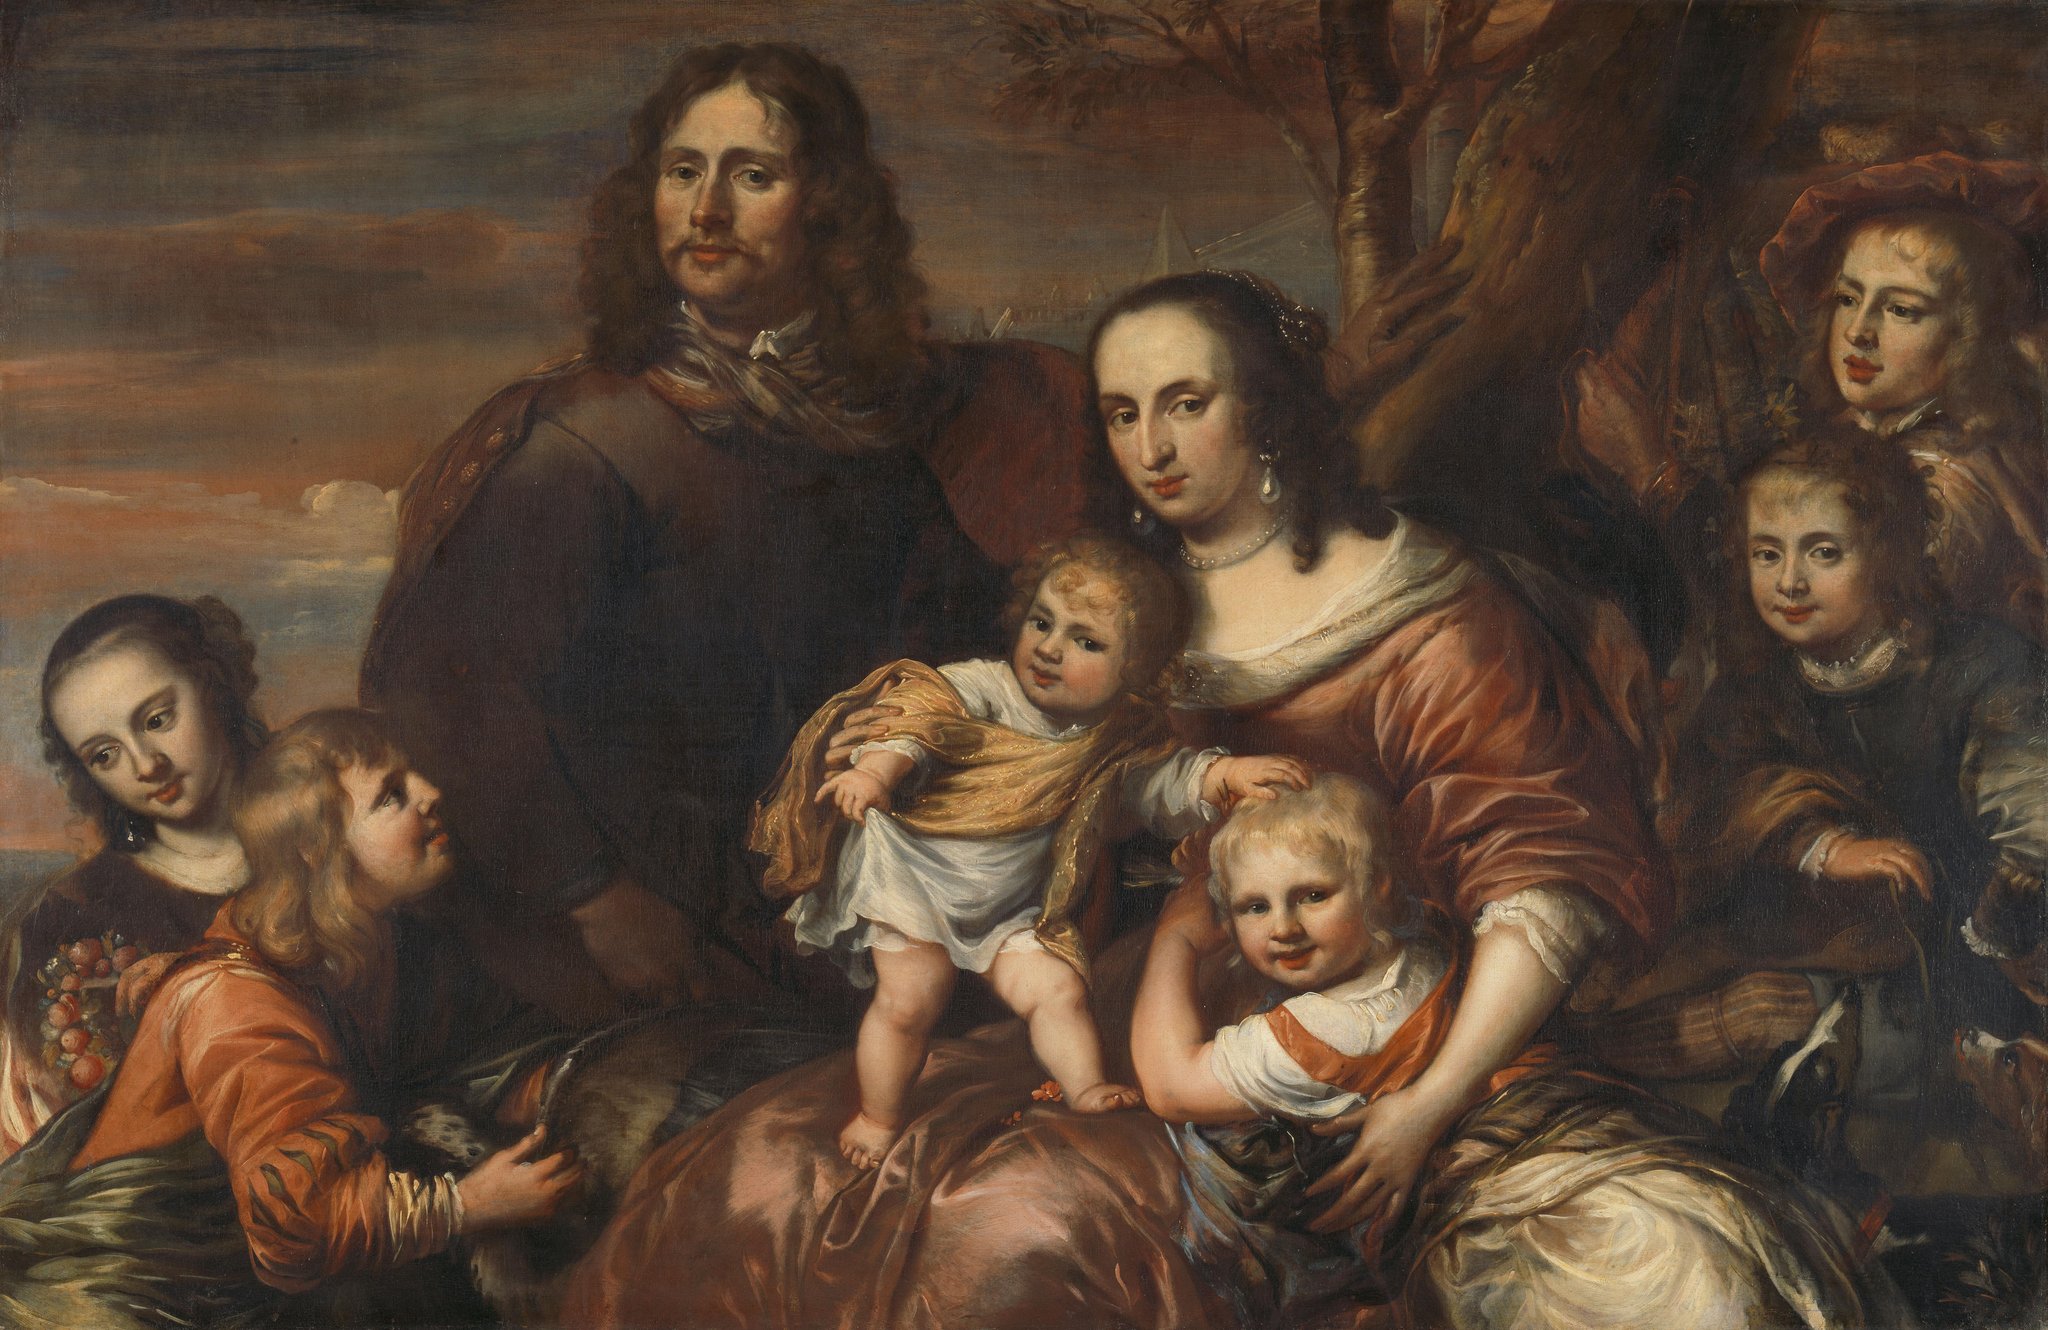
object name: painting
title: A couple with six children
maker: jürgen ovens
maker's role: draughtsman, painter, print maker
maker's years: 1623-1678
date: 1650-1678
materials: canvas, oil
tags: family group, especially parents with their child(ren)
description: Familieportret van een echtpaar omringd door hun zes kinderen. Geportretteerd buiten onder een boom, rechts twee honden.